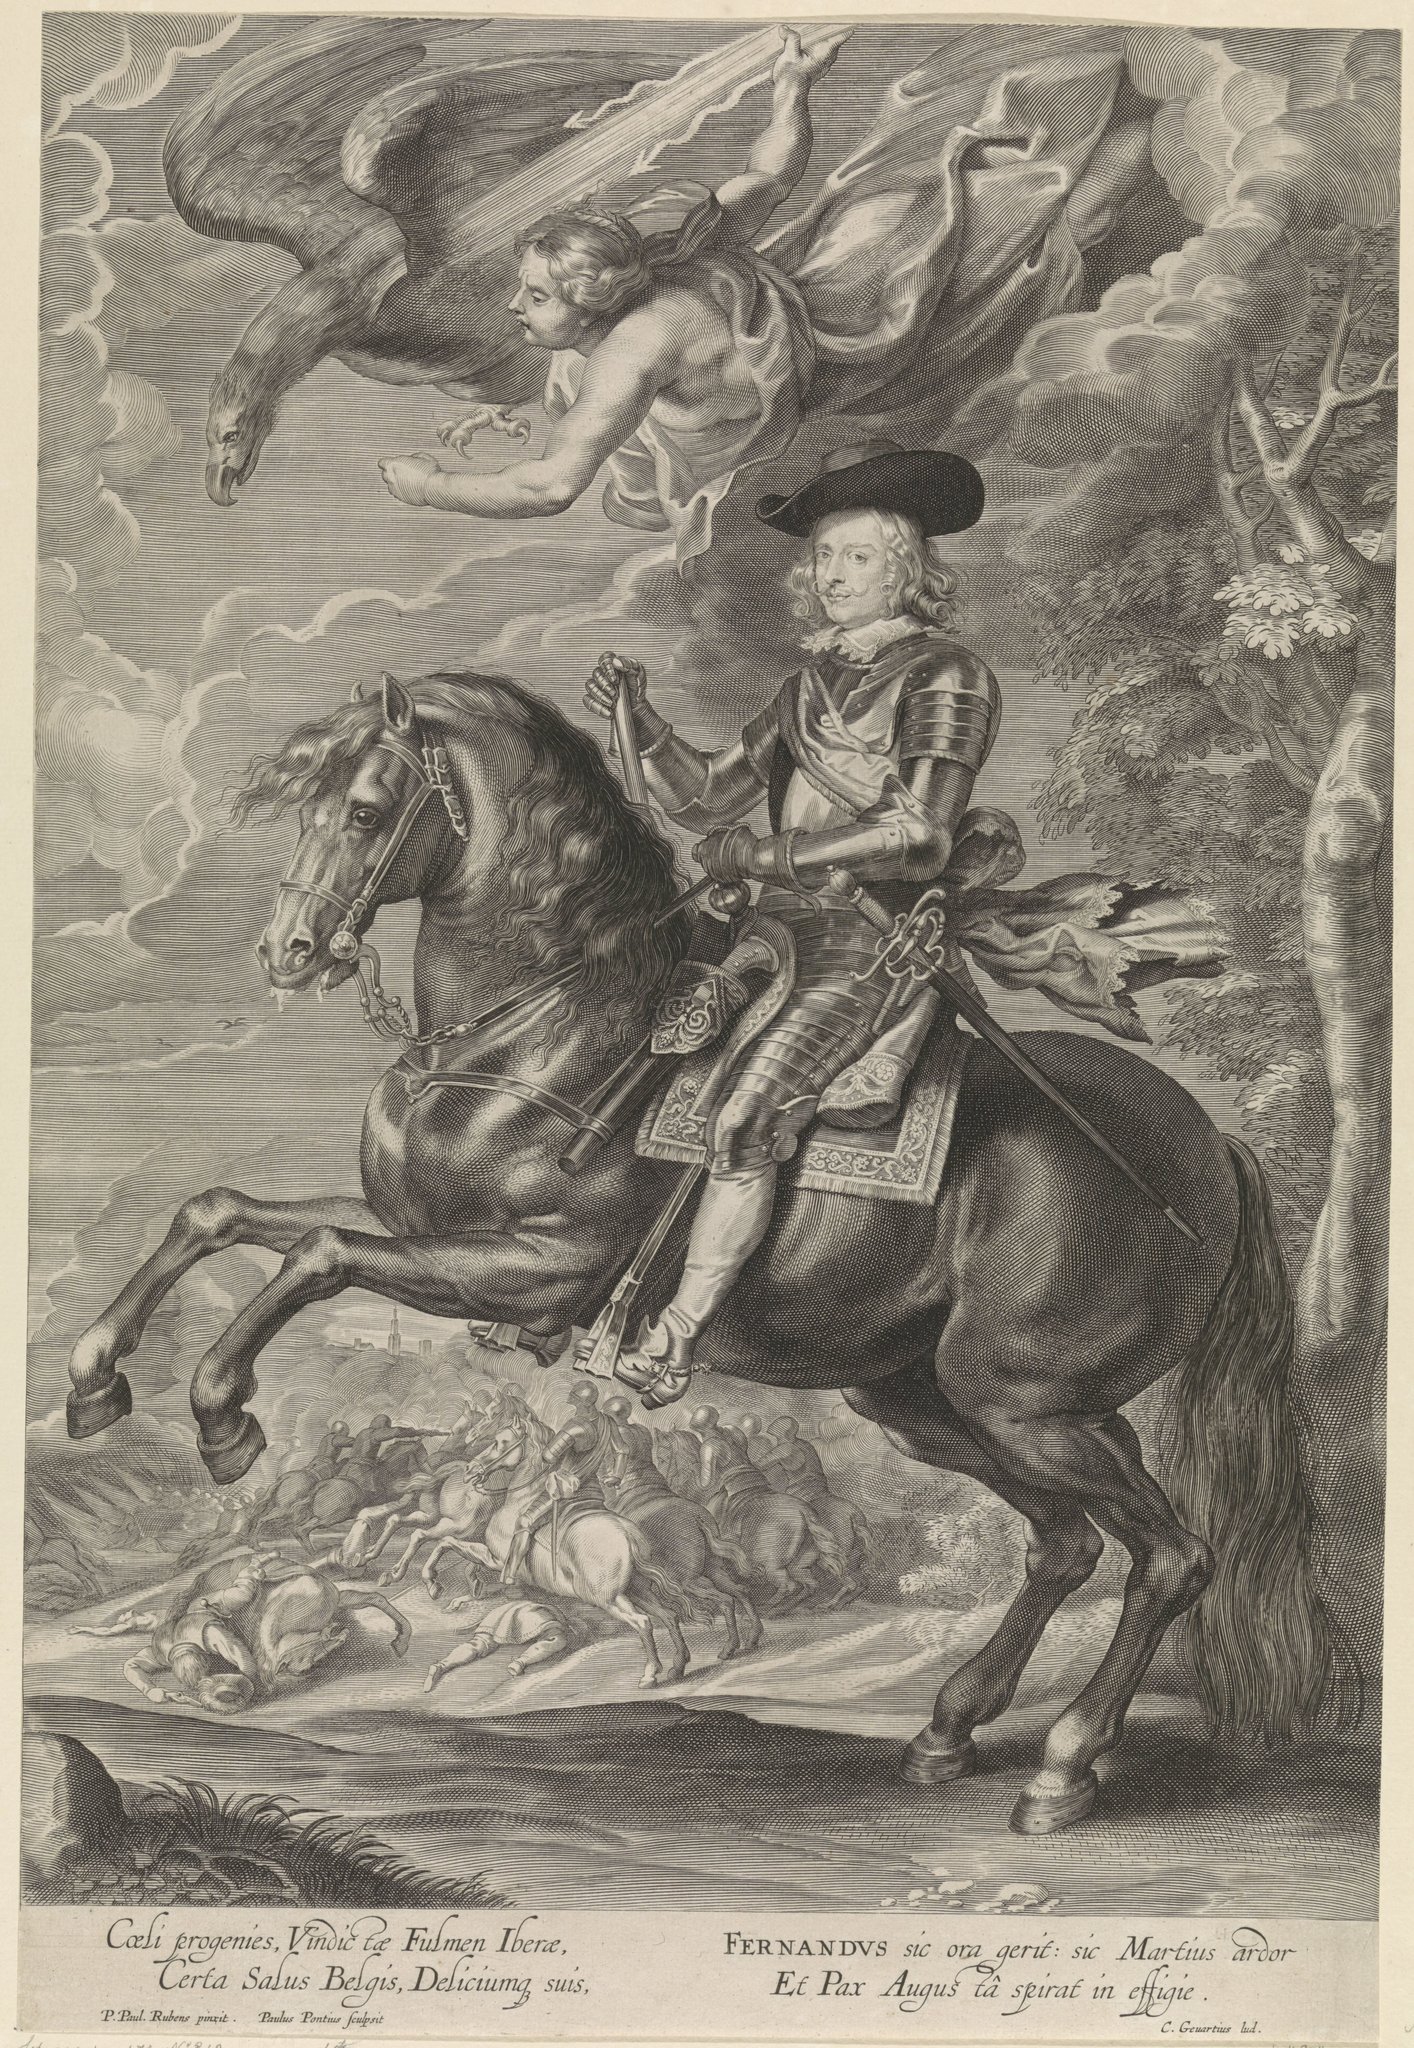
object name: print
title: Ruiterportret van de kardinaal-infant Ferdinand van Oostenrijk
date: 1616-1657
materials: paper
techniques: engraving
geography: antwerp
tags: landvoogd der zuidelijke nederlanden ferdinand van oostenrijk, battle, attributes of jupiter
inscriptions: collector's mark: Lugt 240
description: De kardinaal-infant Ferdinand van Oostenrijk te paard. In de lucht de adelaar en een putto met de bliksemschicht van Jupiter. Op de achtergrond een een veldslag. In de marge een vierregelig lofdicht in het Latijn.